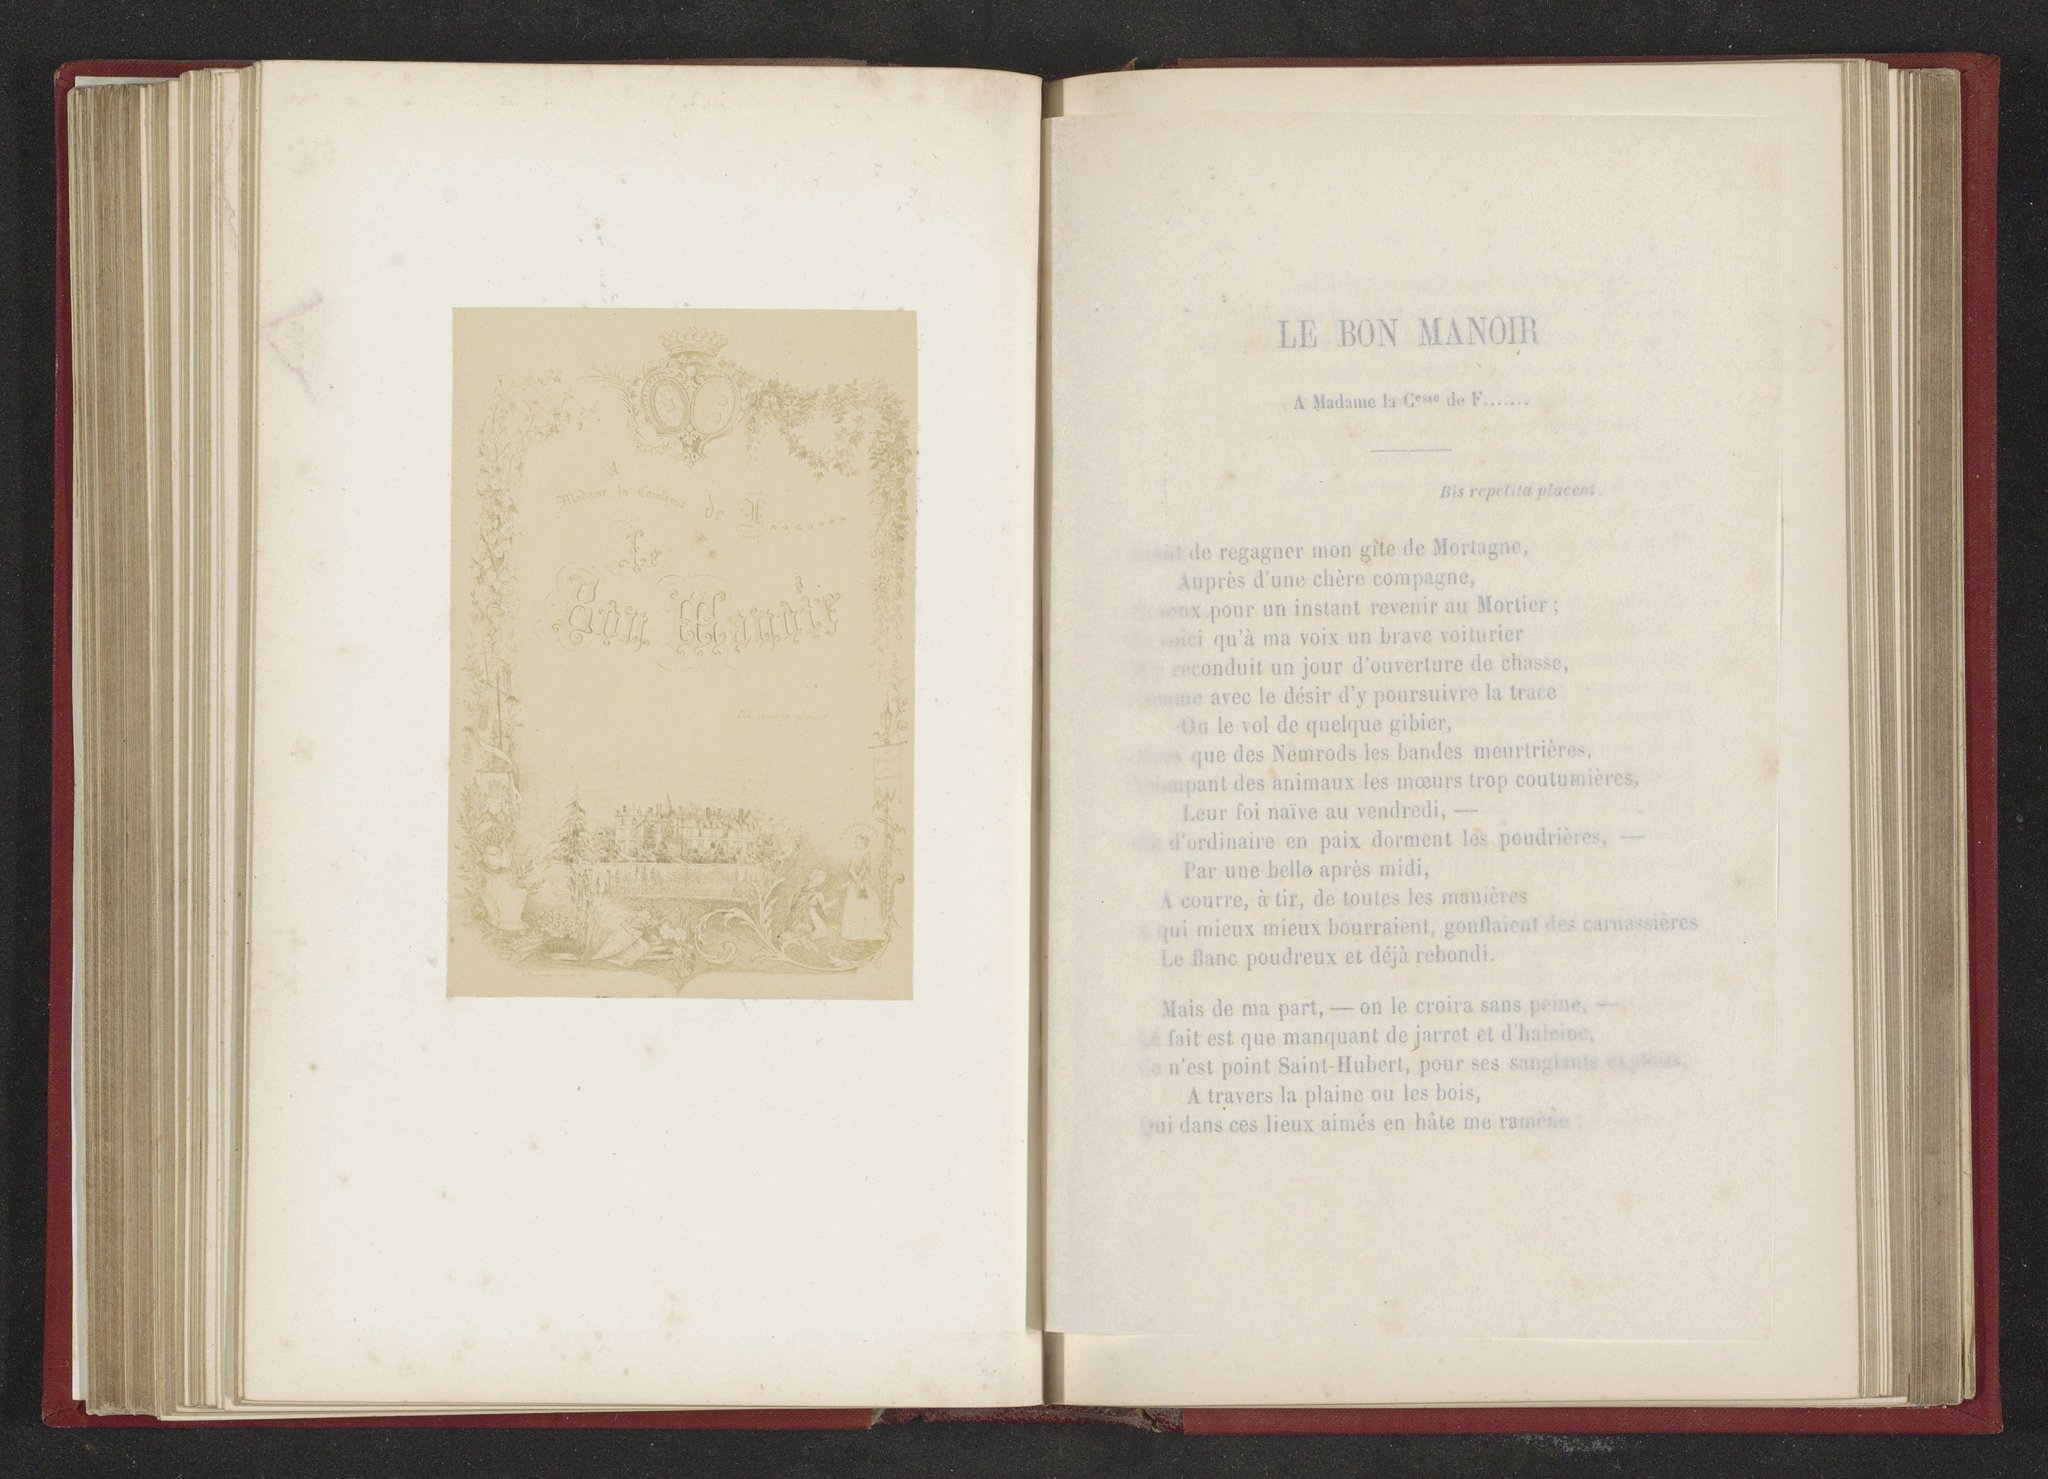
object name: photograph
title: Decoratie met wapenschilden, een aanzoek en een kasteel rond de tekst; Le bon manoir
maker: collin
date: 1858-1868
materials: photographic support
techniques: albumen print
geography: paris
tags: coat of arms (as symbol of the state, etc.), castle, proposal, declaration of love